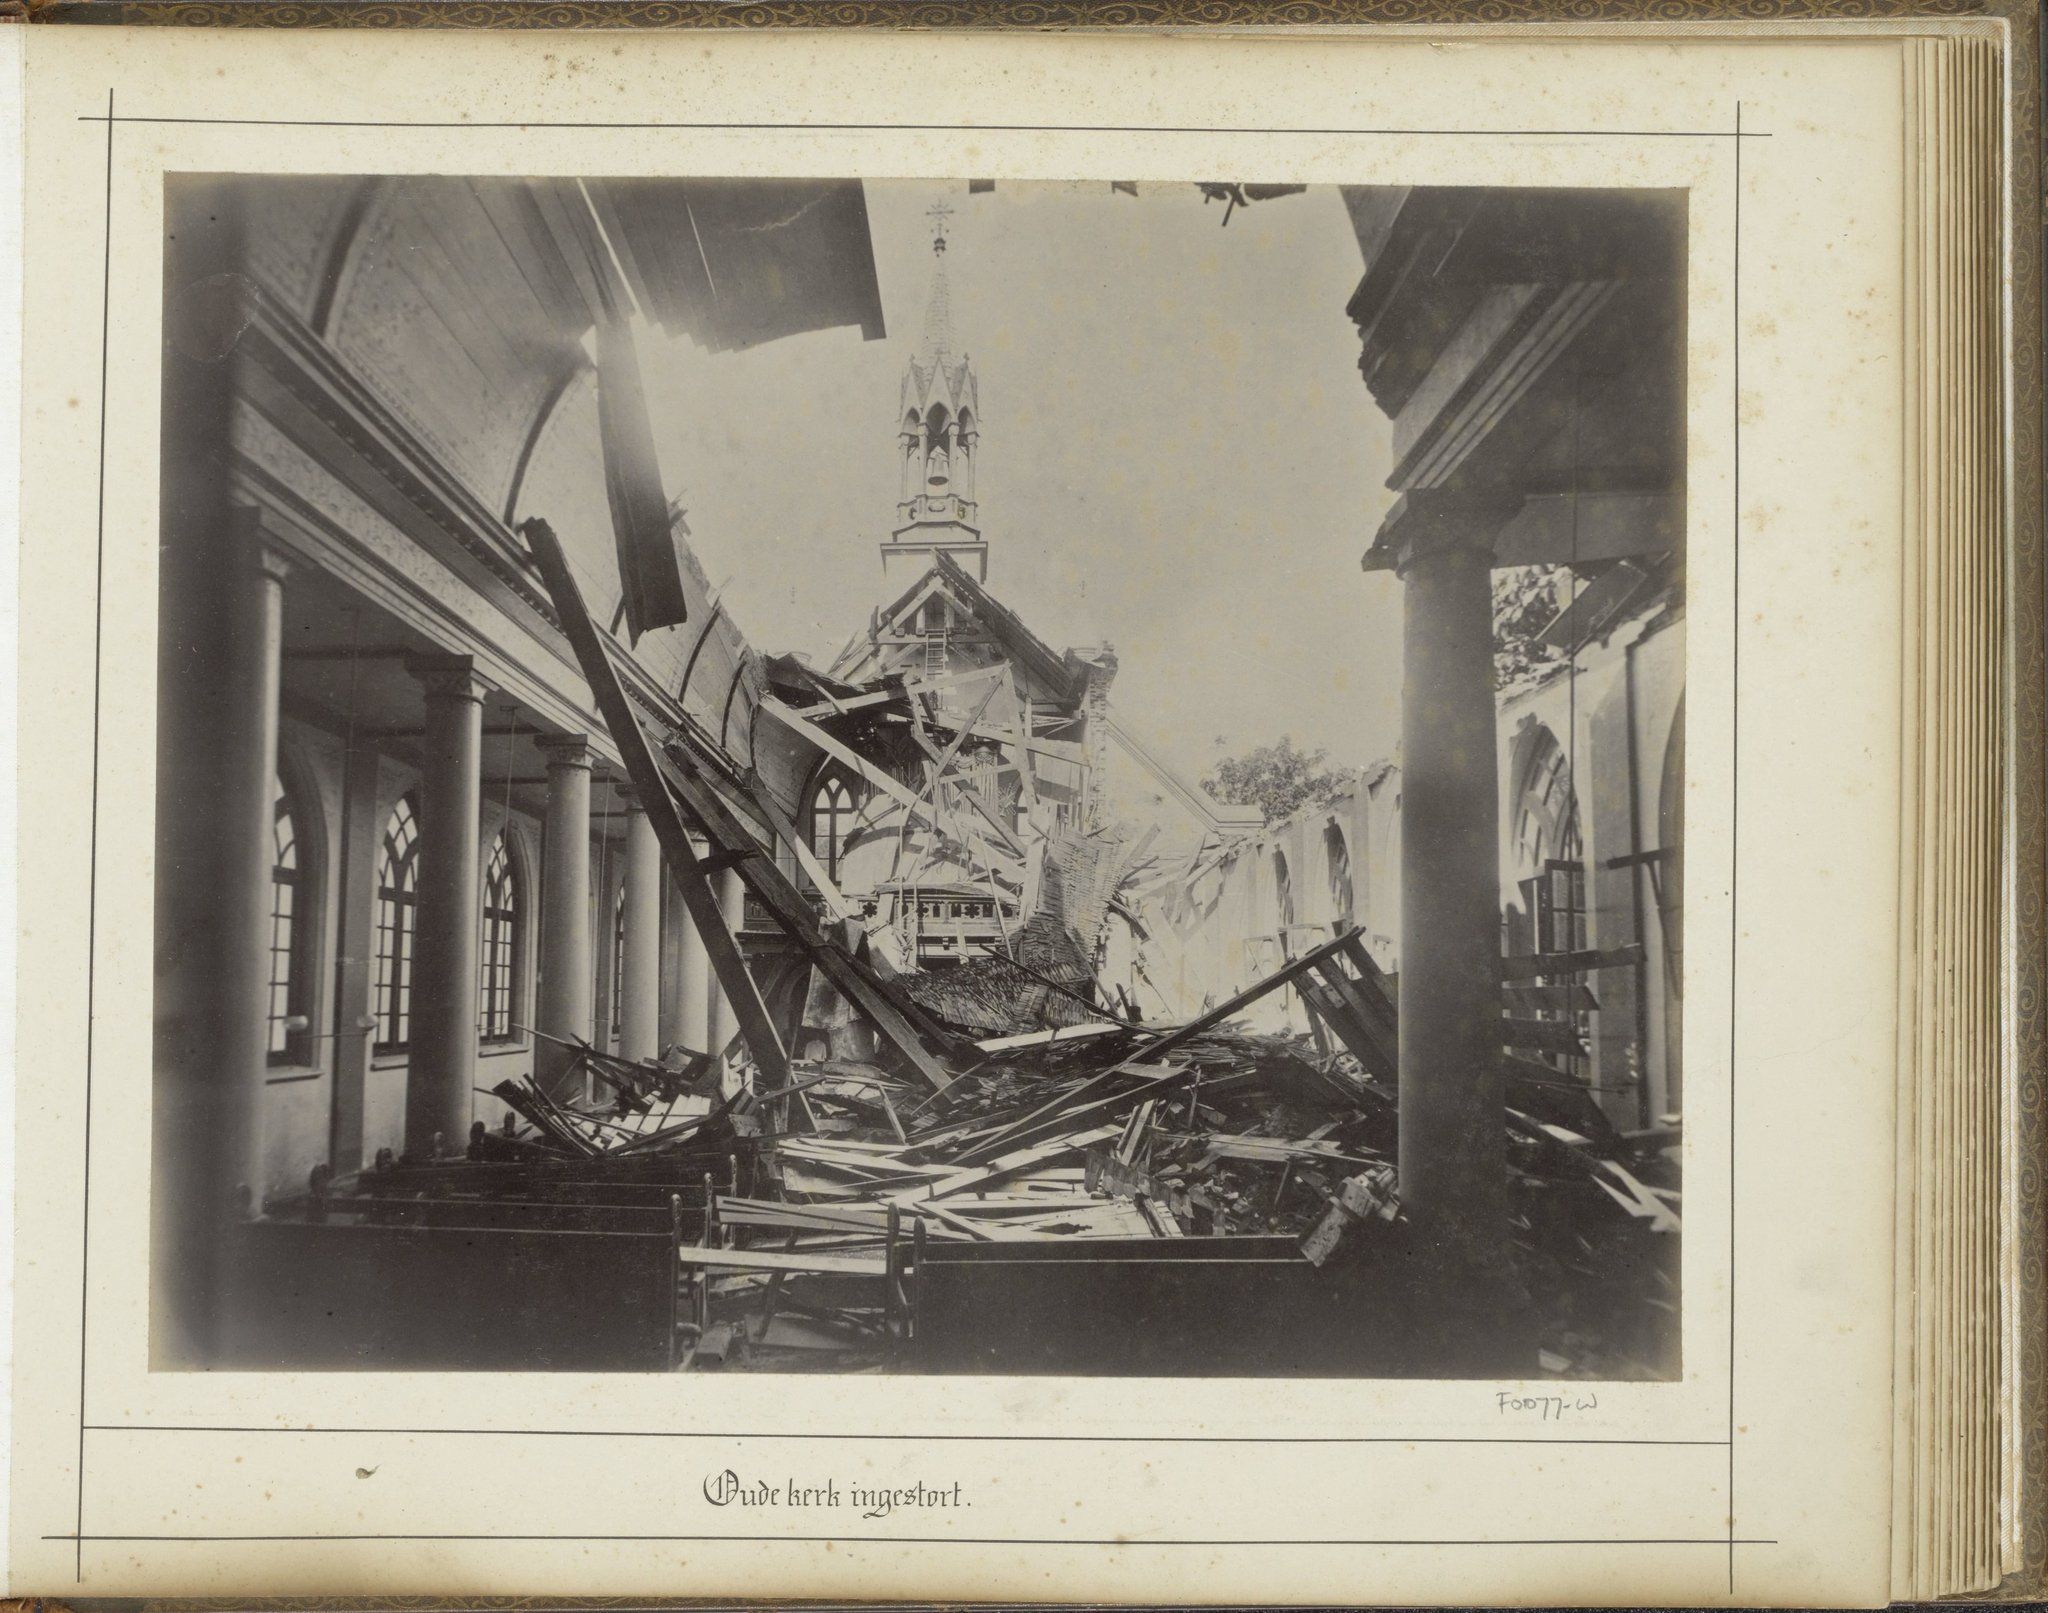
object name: photograph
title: Puinhopen van de ingestorte rooms-katholieke kerk in Batavia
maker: Anonymous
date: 1890-1910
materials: paper, photographic support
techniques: albumen print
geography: batavia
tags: collapsing building, batavia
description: Onderdeel van Album met foto's van Batavia en van de zusters Ursulinen.